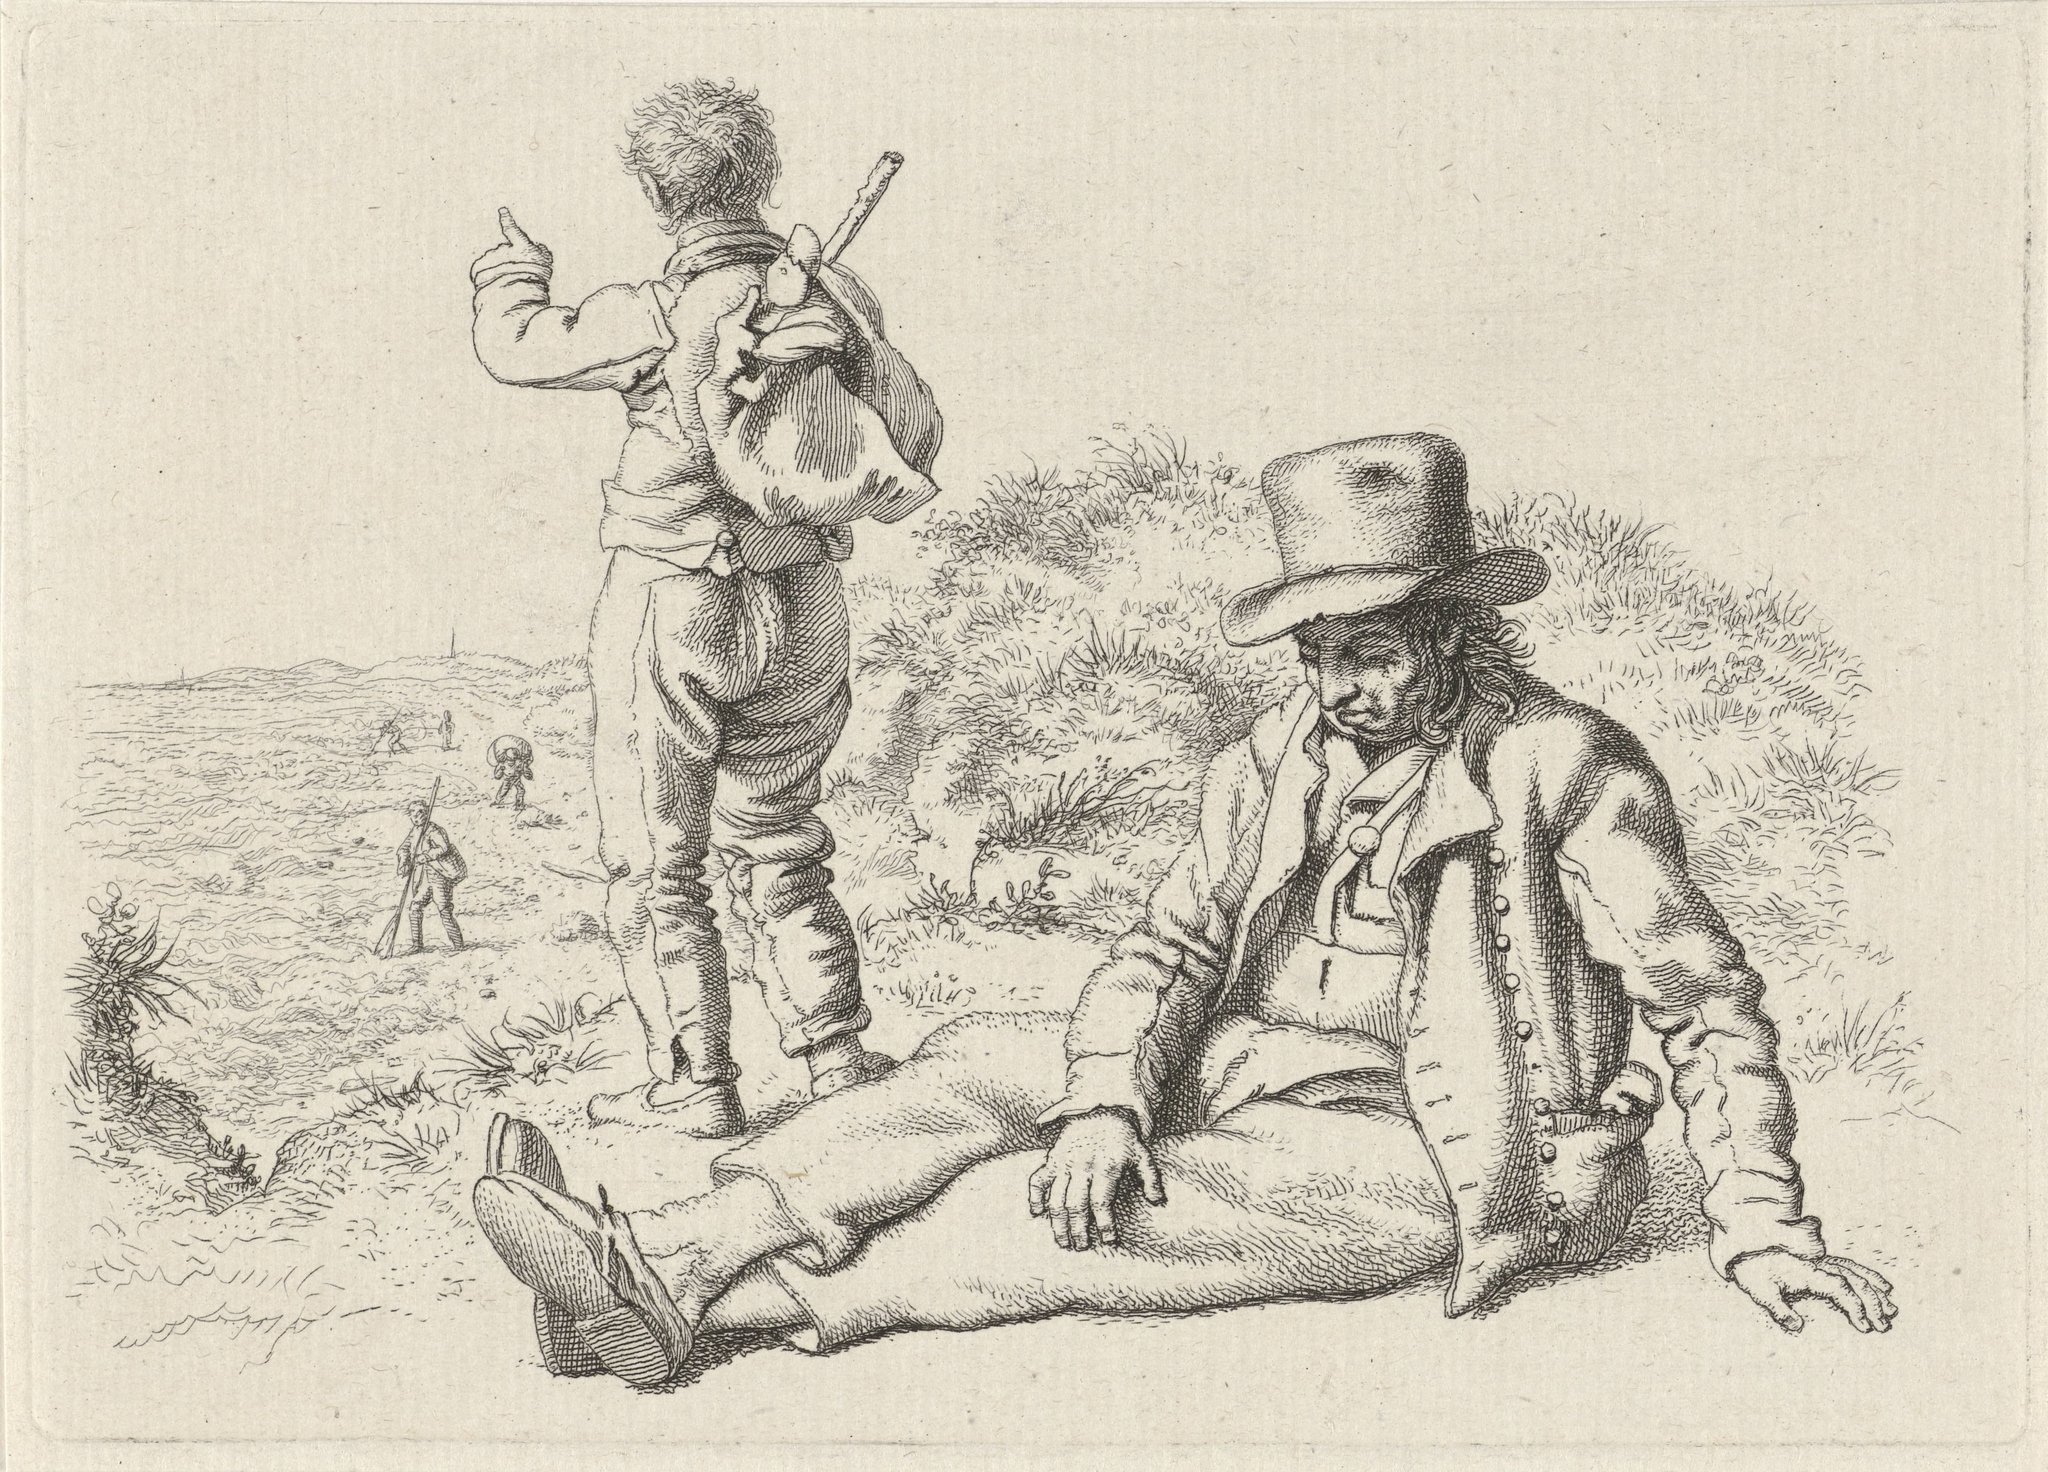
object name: print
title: Studie-prentwerk / Etudes gravées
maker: jacob ernst marcus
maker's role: draughtsman, print maker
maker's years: 1774-1826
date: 1811-1812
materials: paper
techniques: etching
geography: amsterdam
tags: sitting figure, index finger forwards, pointing, indicating, dune coast (+ landscape with figures, staffage)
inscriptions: collector's mark: Lugt 2228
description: Serie voor het eerst uitgegeven door Jacob Ernst Marcus onder de titel Studiebeelden en Fragmenten. Amsterdam: ca.1816. Later heruitgegeven als: Studie-prentwerk/ Etudes gravées.